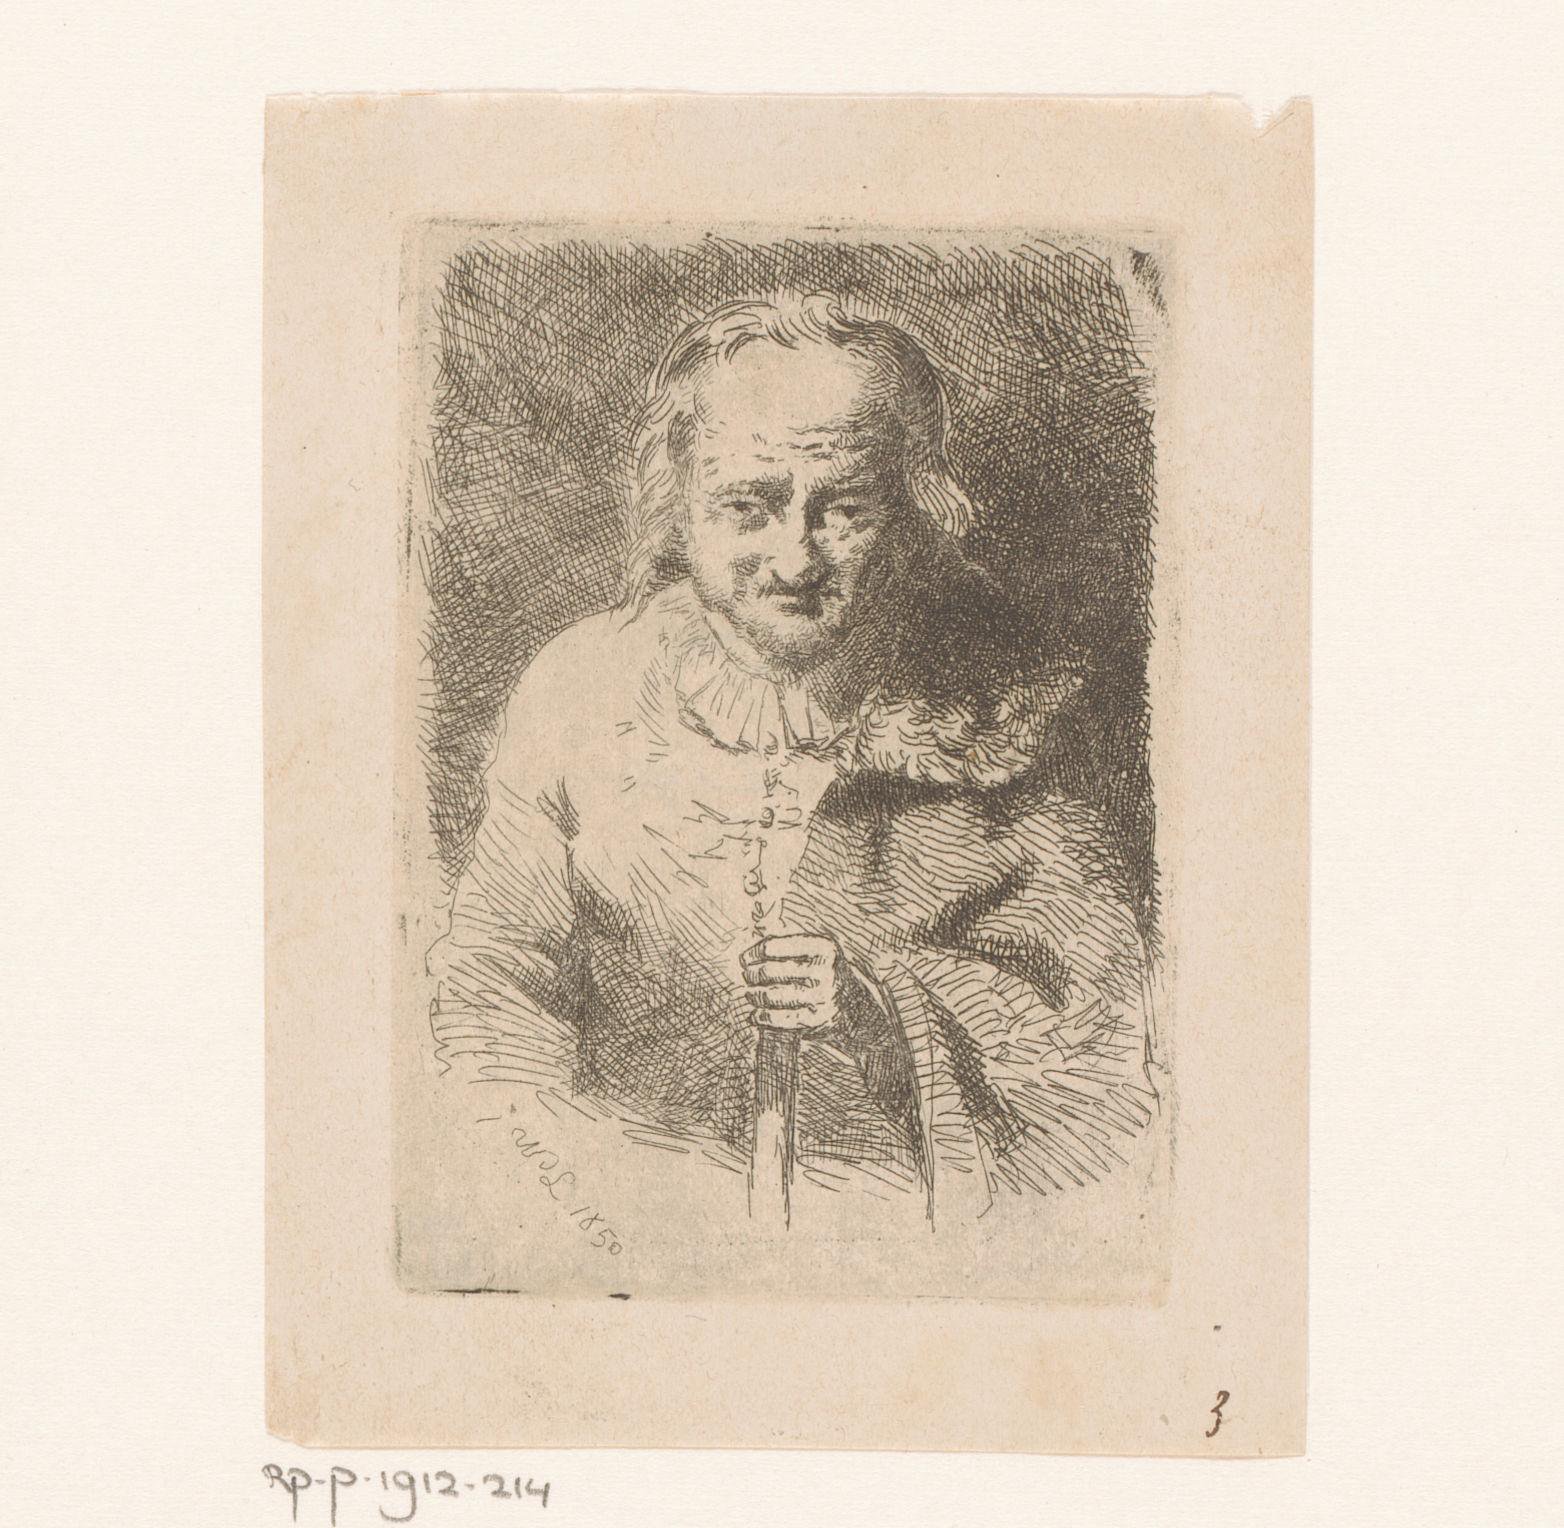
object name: print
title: Oude man met een stok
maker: willem linnig (i)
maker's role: print maker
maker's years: 1819-1885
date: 1850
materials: paper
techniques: etching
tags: walking-stick, staff, old man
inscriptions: collector's mark: Lugt 2228, collector's mark: Lugt 1485